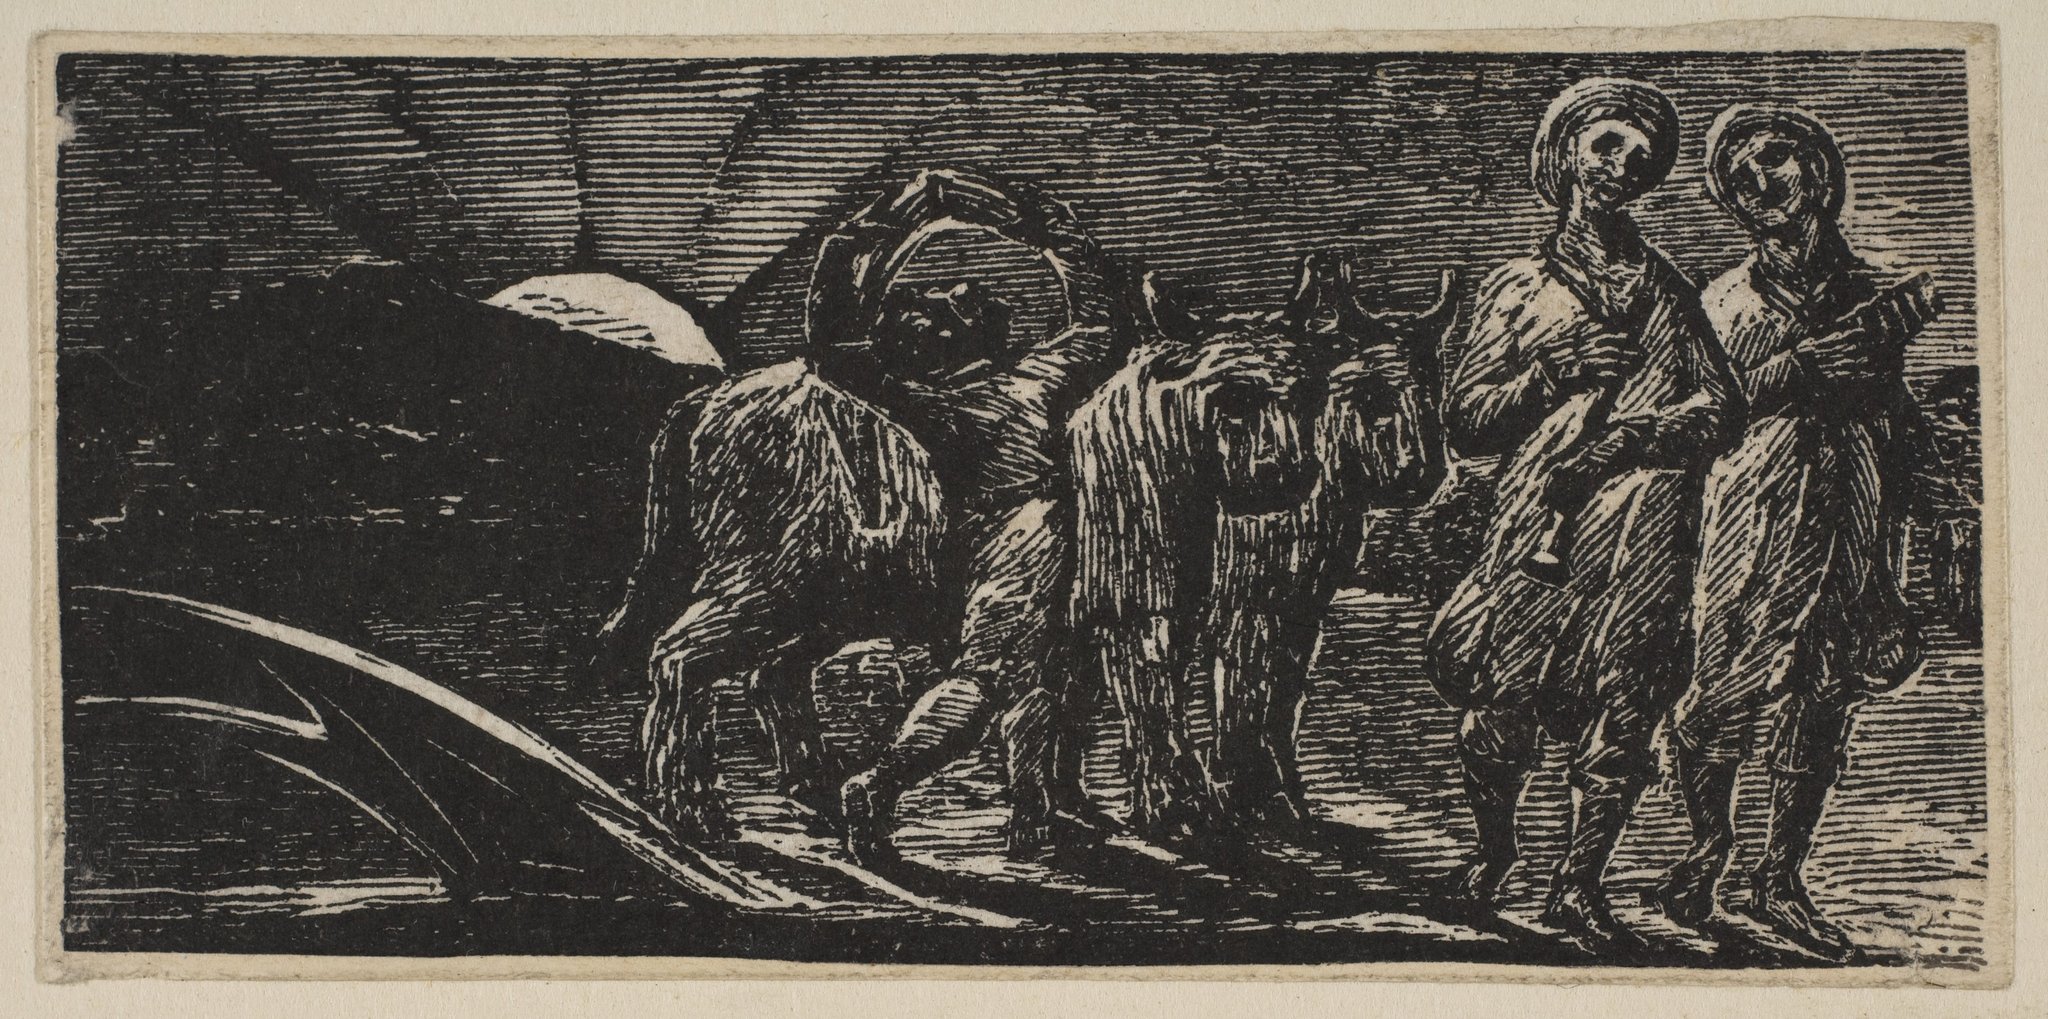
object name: print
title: Boy Returning Joyfully, with Plough and Oxen, from Thornton's "Pastorals of Virgil"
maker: william blake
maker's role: artist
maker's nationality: british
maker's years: 1757-1827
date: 1821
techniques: engraving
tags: animals,boys